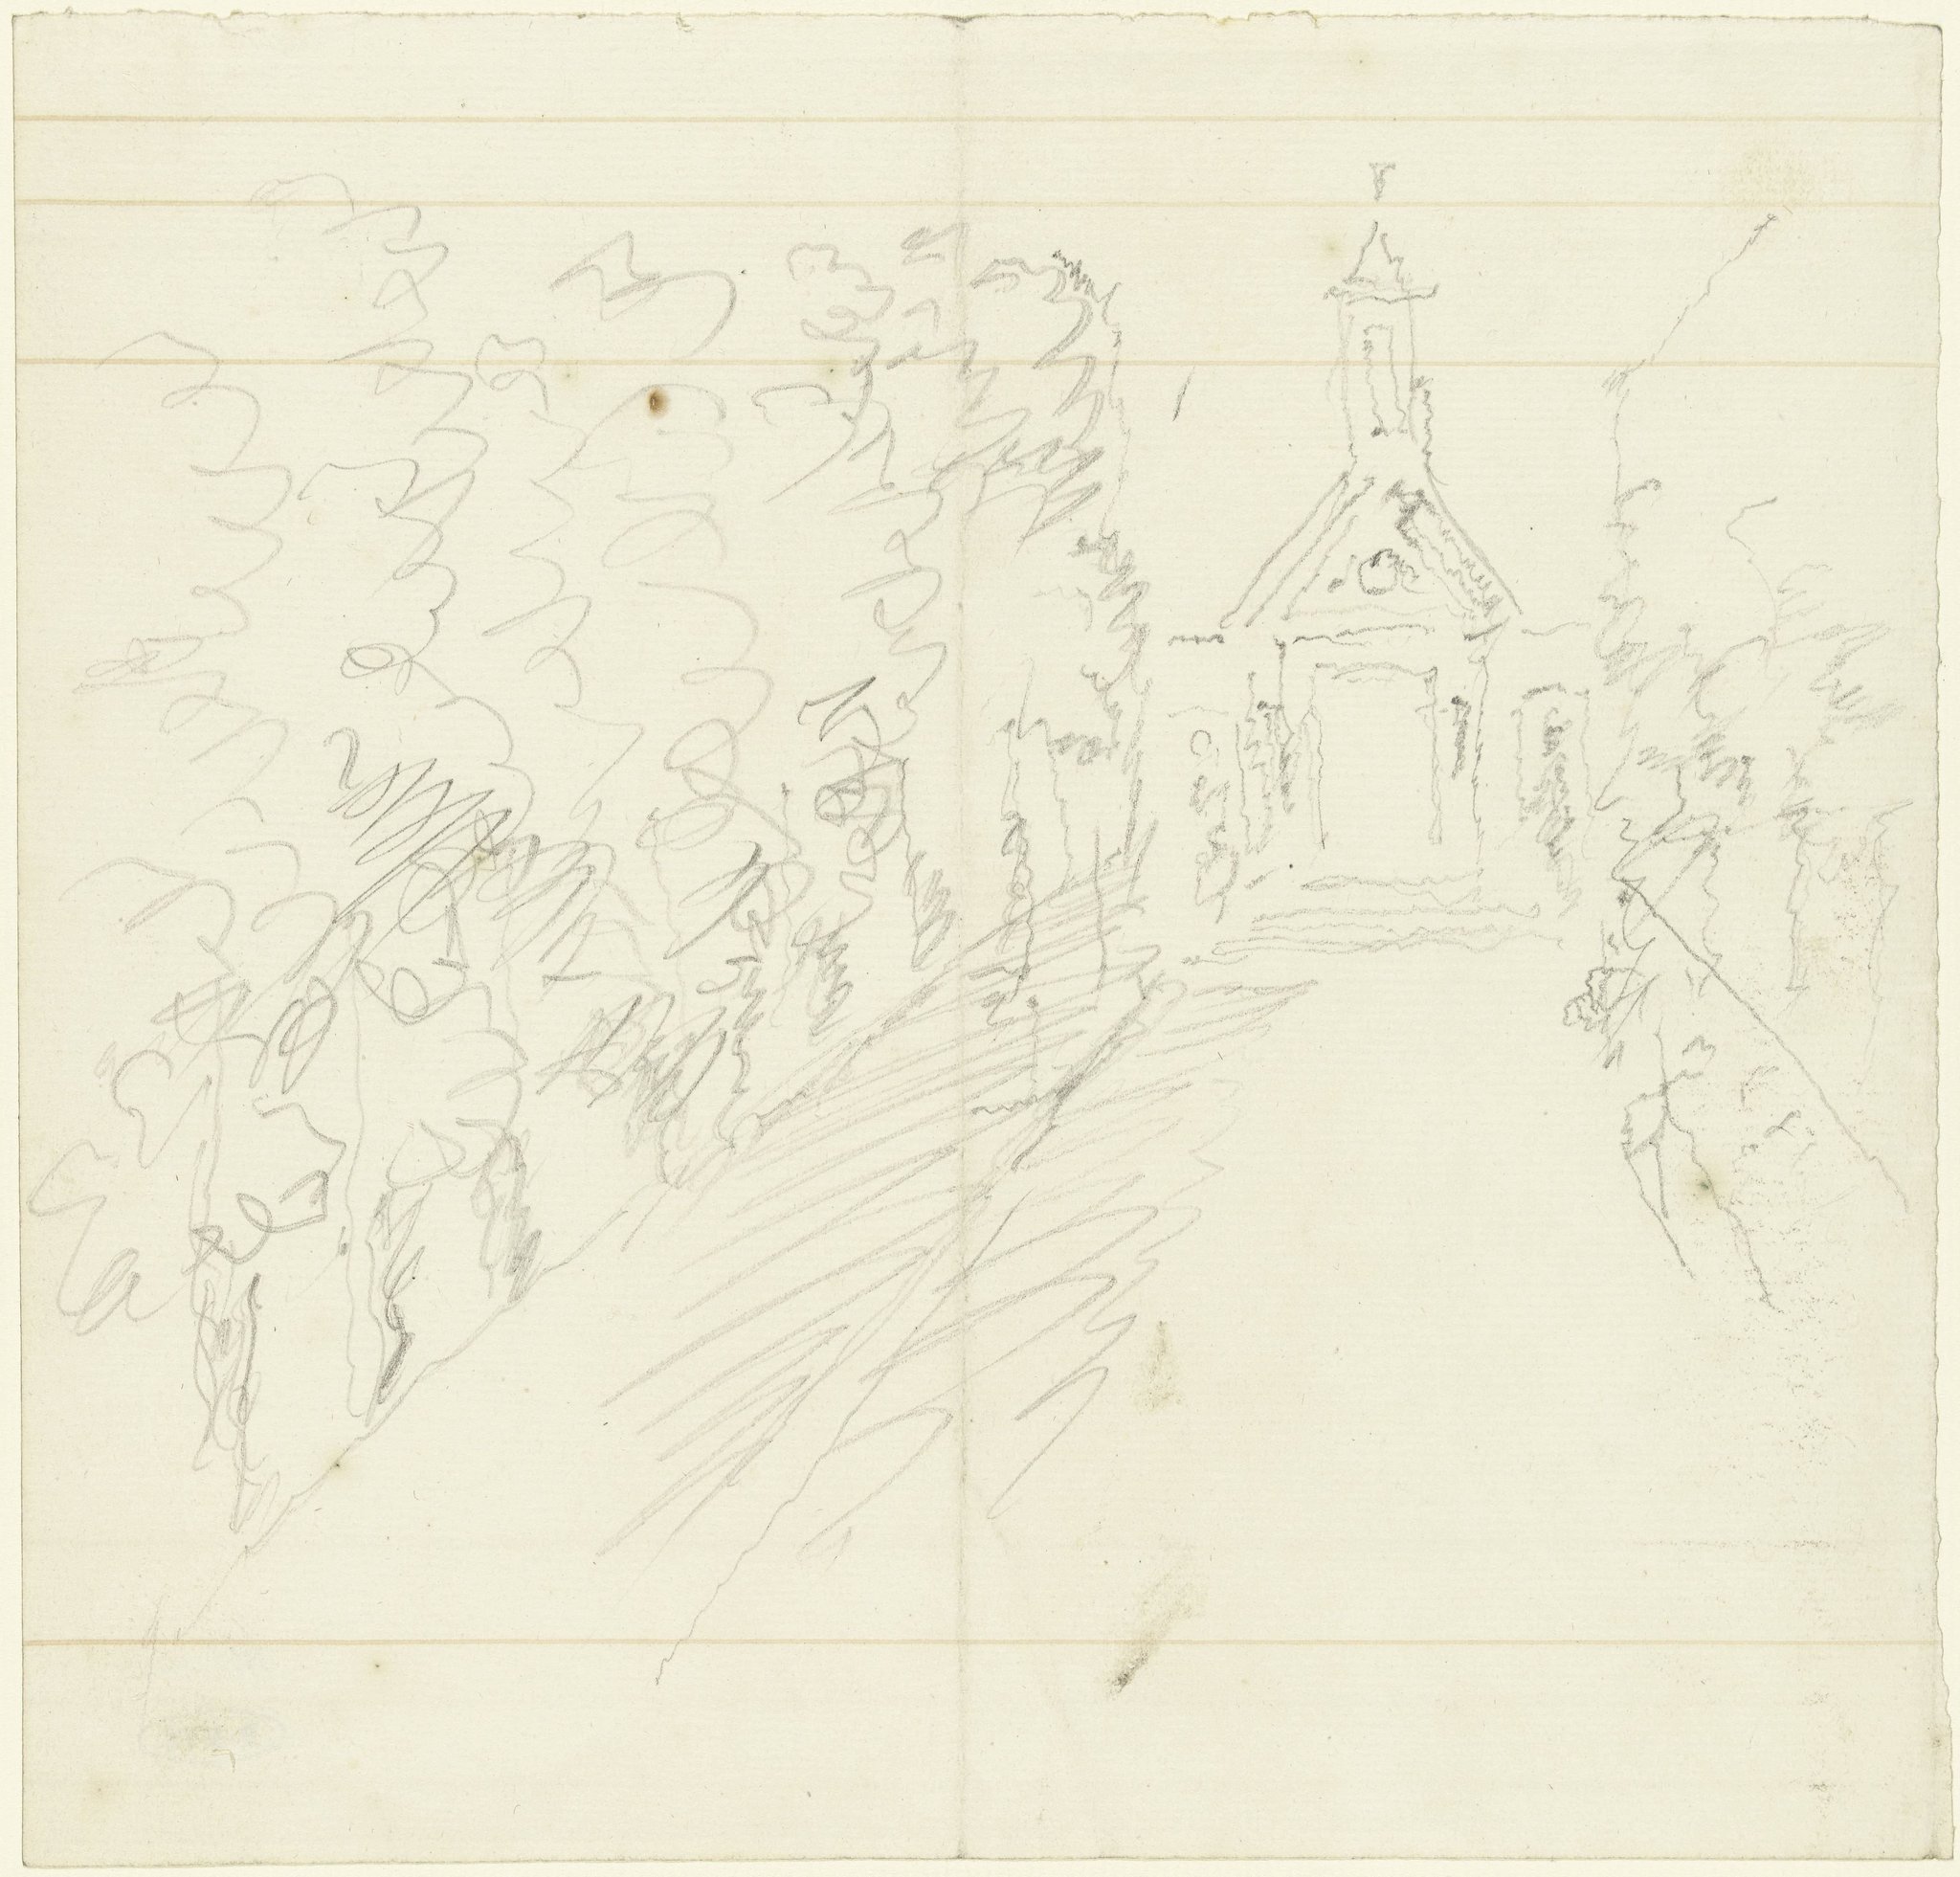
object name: design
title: Ontwerp voor een zaalstuk: tuinhuis aan het eind van een laan met bomen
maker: dionys van nijmegen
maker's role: draughtsman, painter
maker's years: 1705-1798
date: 1715-1798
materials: paper, pencil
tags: garden